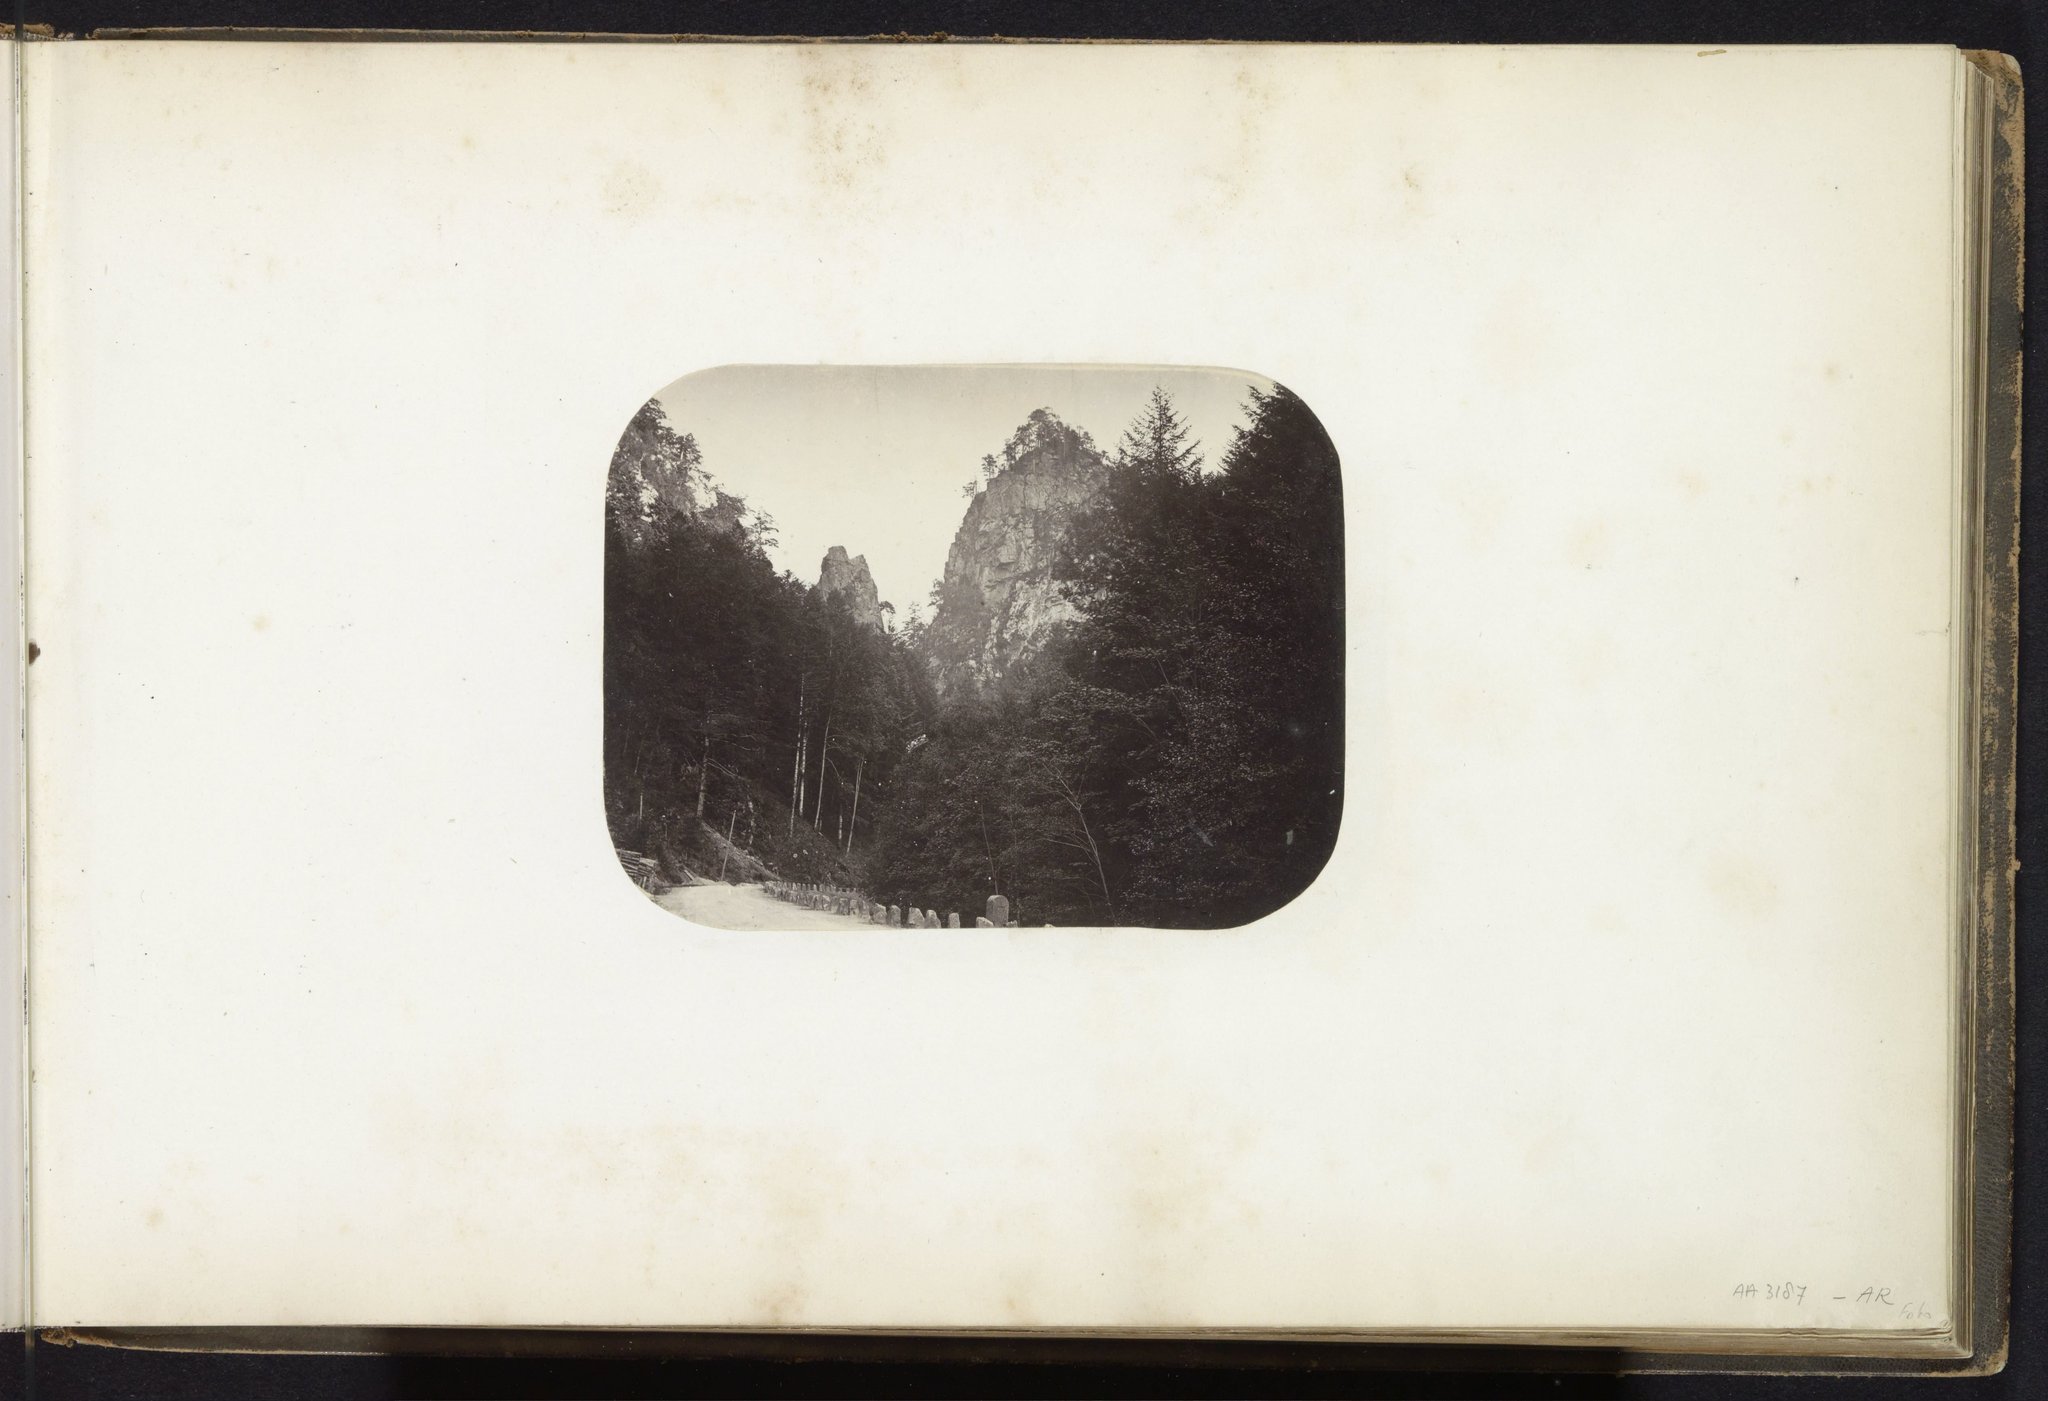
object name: photograph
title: Berglandschap met weg en steile rotswand, mogelijk in de Alpen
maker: Anonymous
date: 1865-1875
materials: photographic support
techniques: albumen print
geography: alps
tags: inland cliff face, road, path, mountains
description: Onderdeel van Reisalbum met opnames van bezienswaardigheden in India, Duitsland, Zwitserland en Frankrijk.